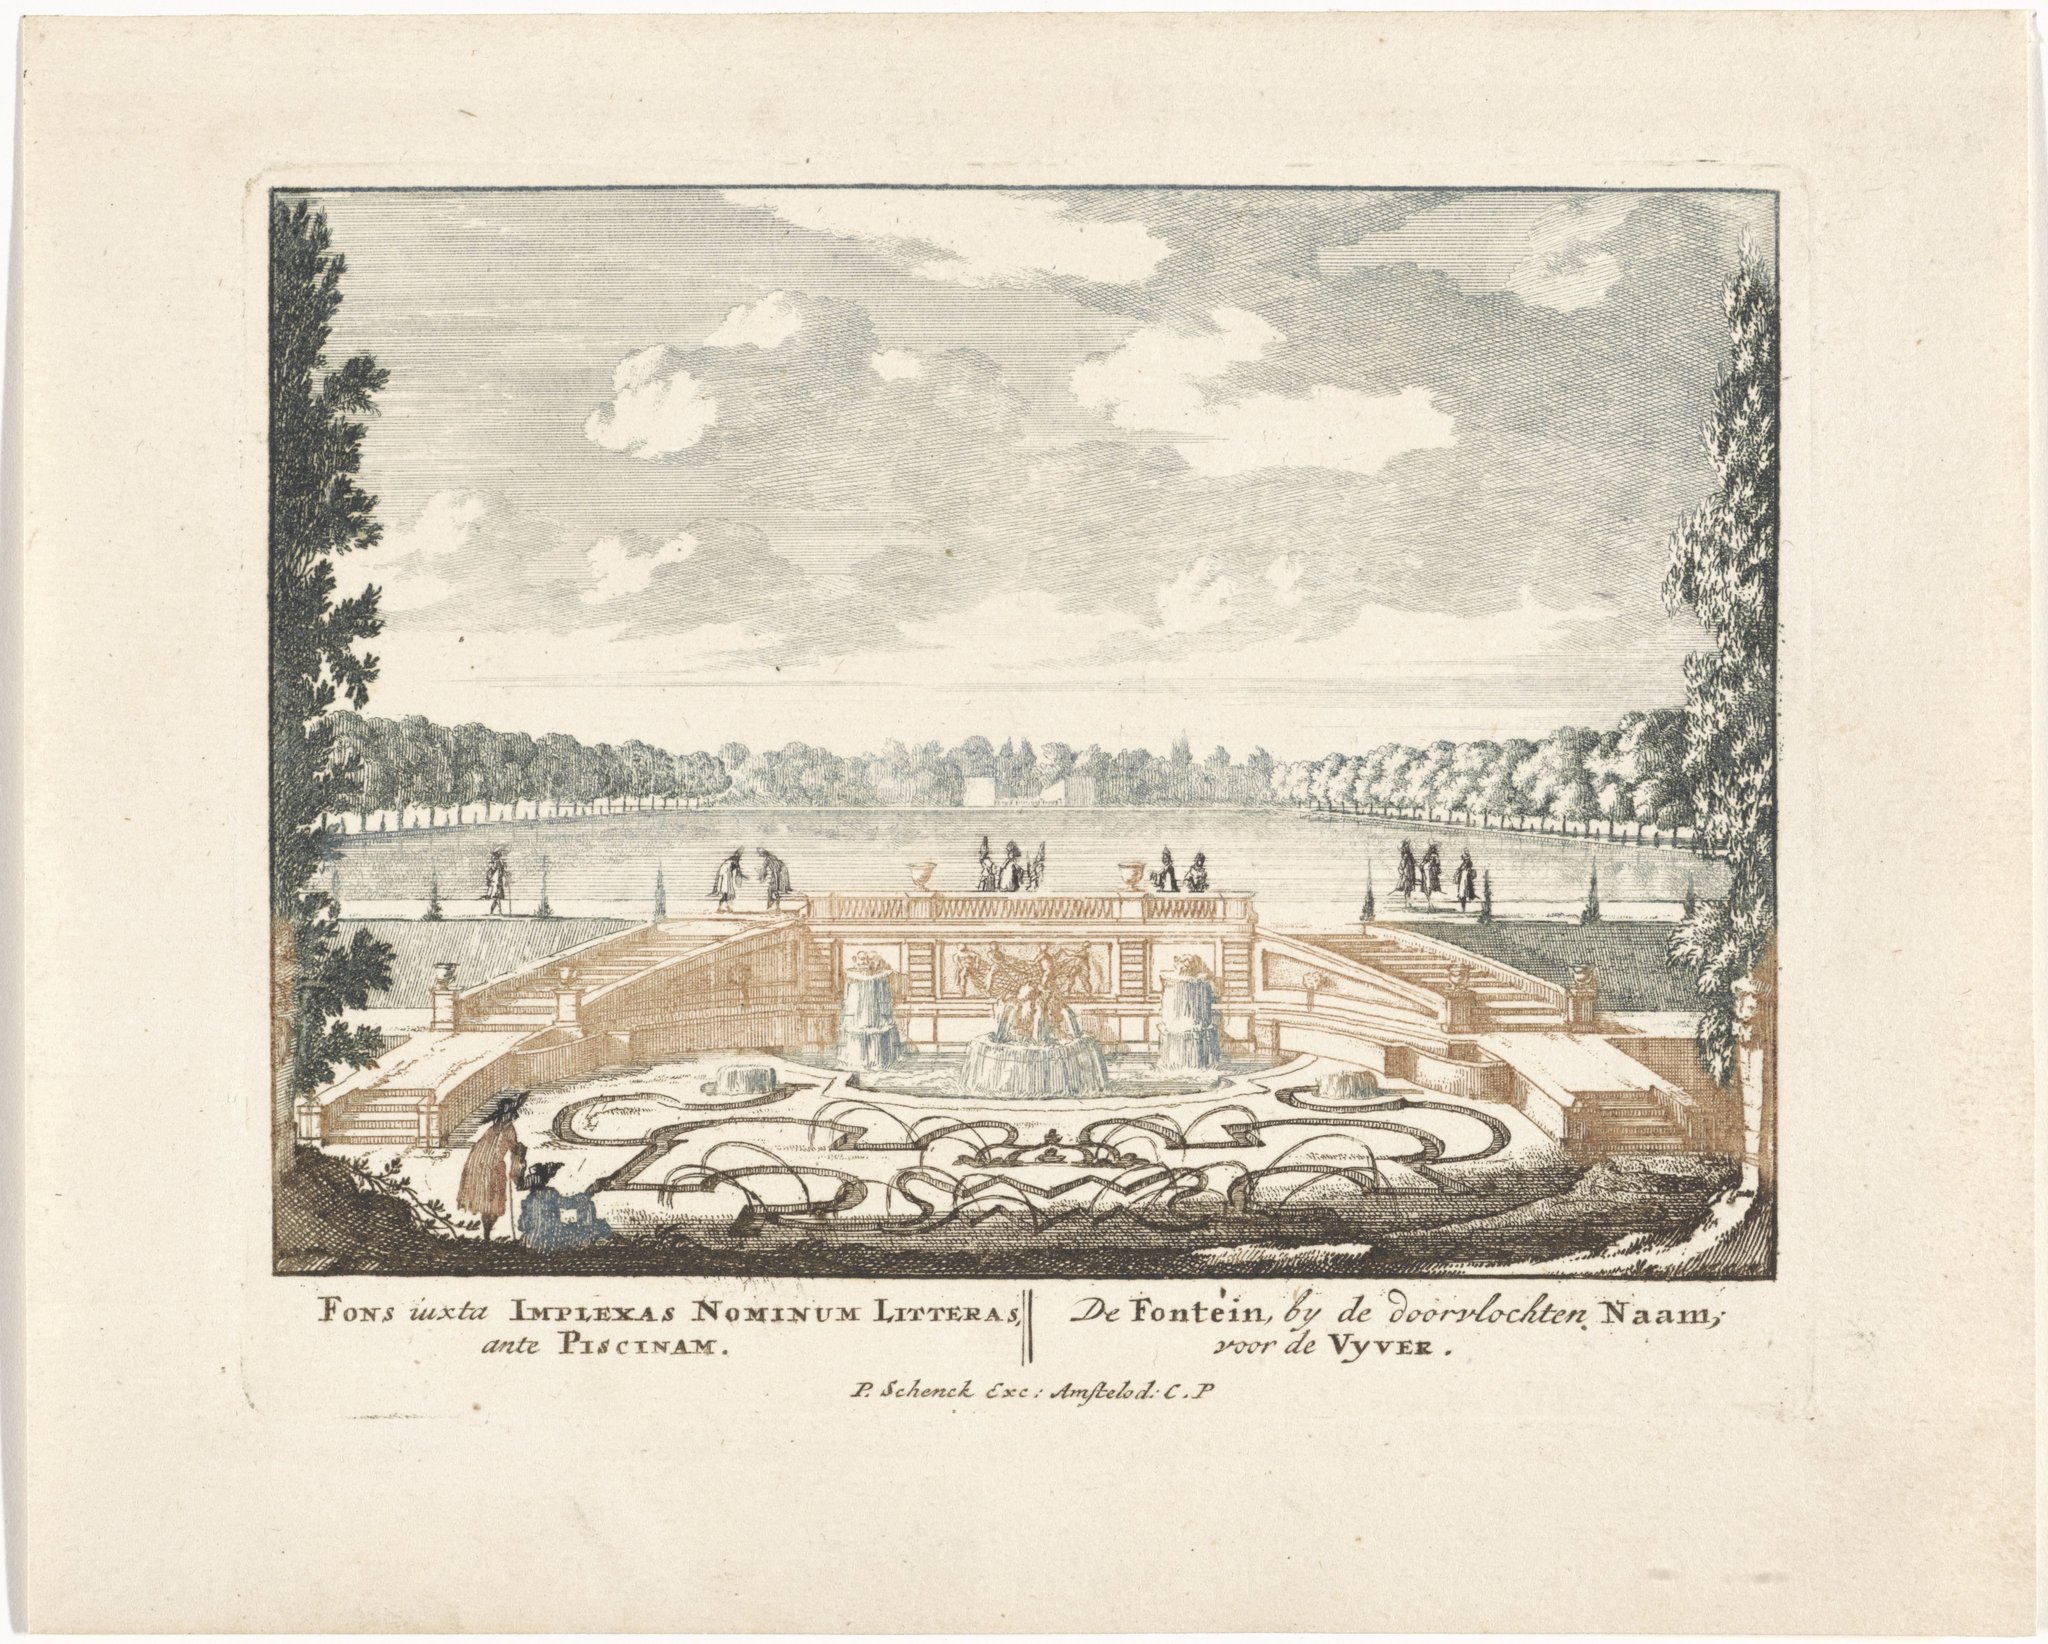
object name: print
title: Admirandorum quadruplex spectaculum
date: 1694-1697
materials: paper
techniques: etching, hand coloring, lithography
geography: amsterdam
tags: garden fountain, french or architectonic garden; formal garden, garden pond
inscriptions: collector's mark: Lugt 2228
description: Prent uit een serie van 71 prenten met Rijnlandschappen, gezichten op vorstelijke paleizen en stadsgezichten uit Den Haag en Amsterdam.